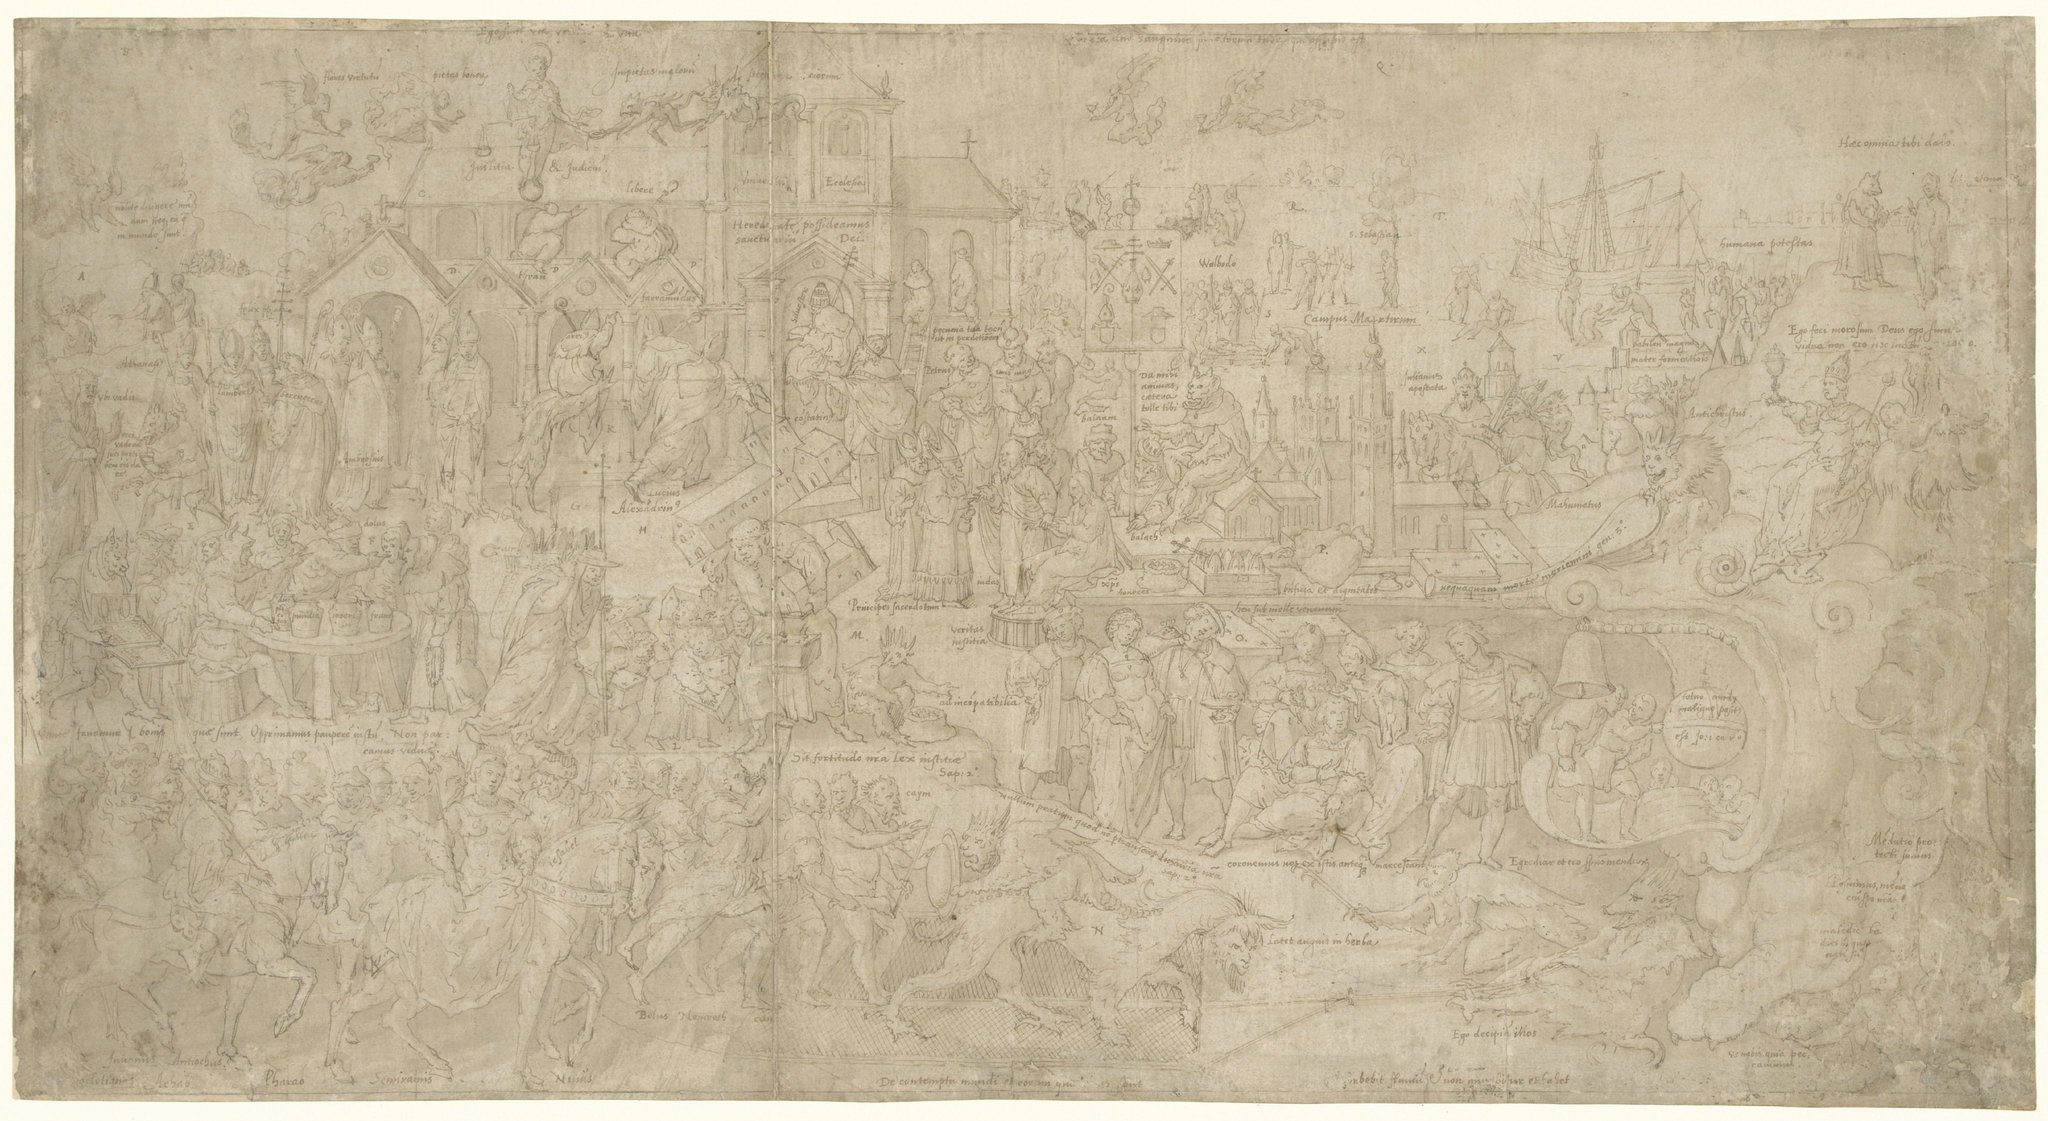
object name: drawing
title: Satire op het machtsmisbruik van de rooms-katholieke geestelijkheid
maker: bernard van orley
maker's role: draughtsman, painter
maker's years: 1487-1542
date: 1527-1541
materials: chalk, ink, paper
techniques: brush, pen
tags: entrance of hell as monstrous mouth (of leviathan), (aspects of) christian religion or the church (as institution) ridiculed, criticized, or caricaturized, abuses of the clergy, e.g. simony